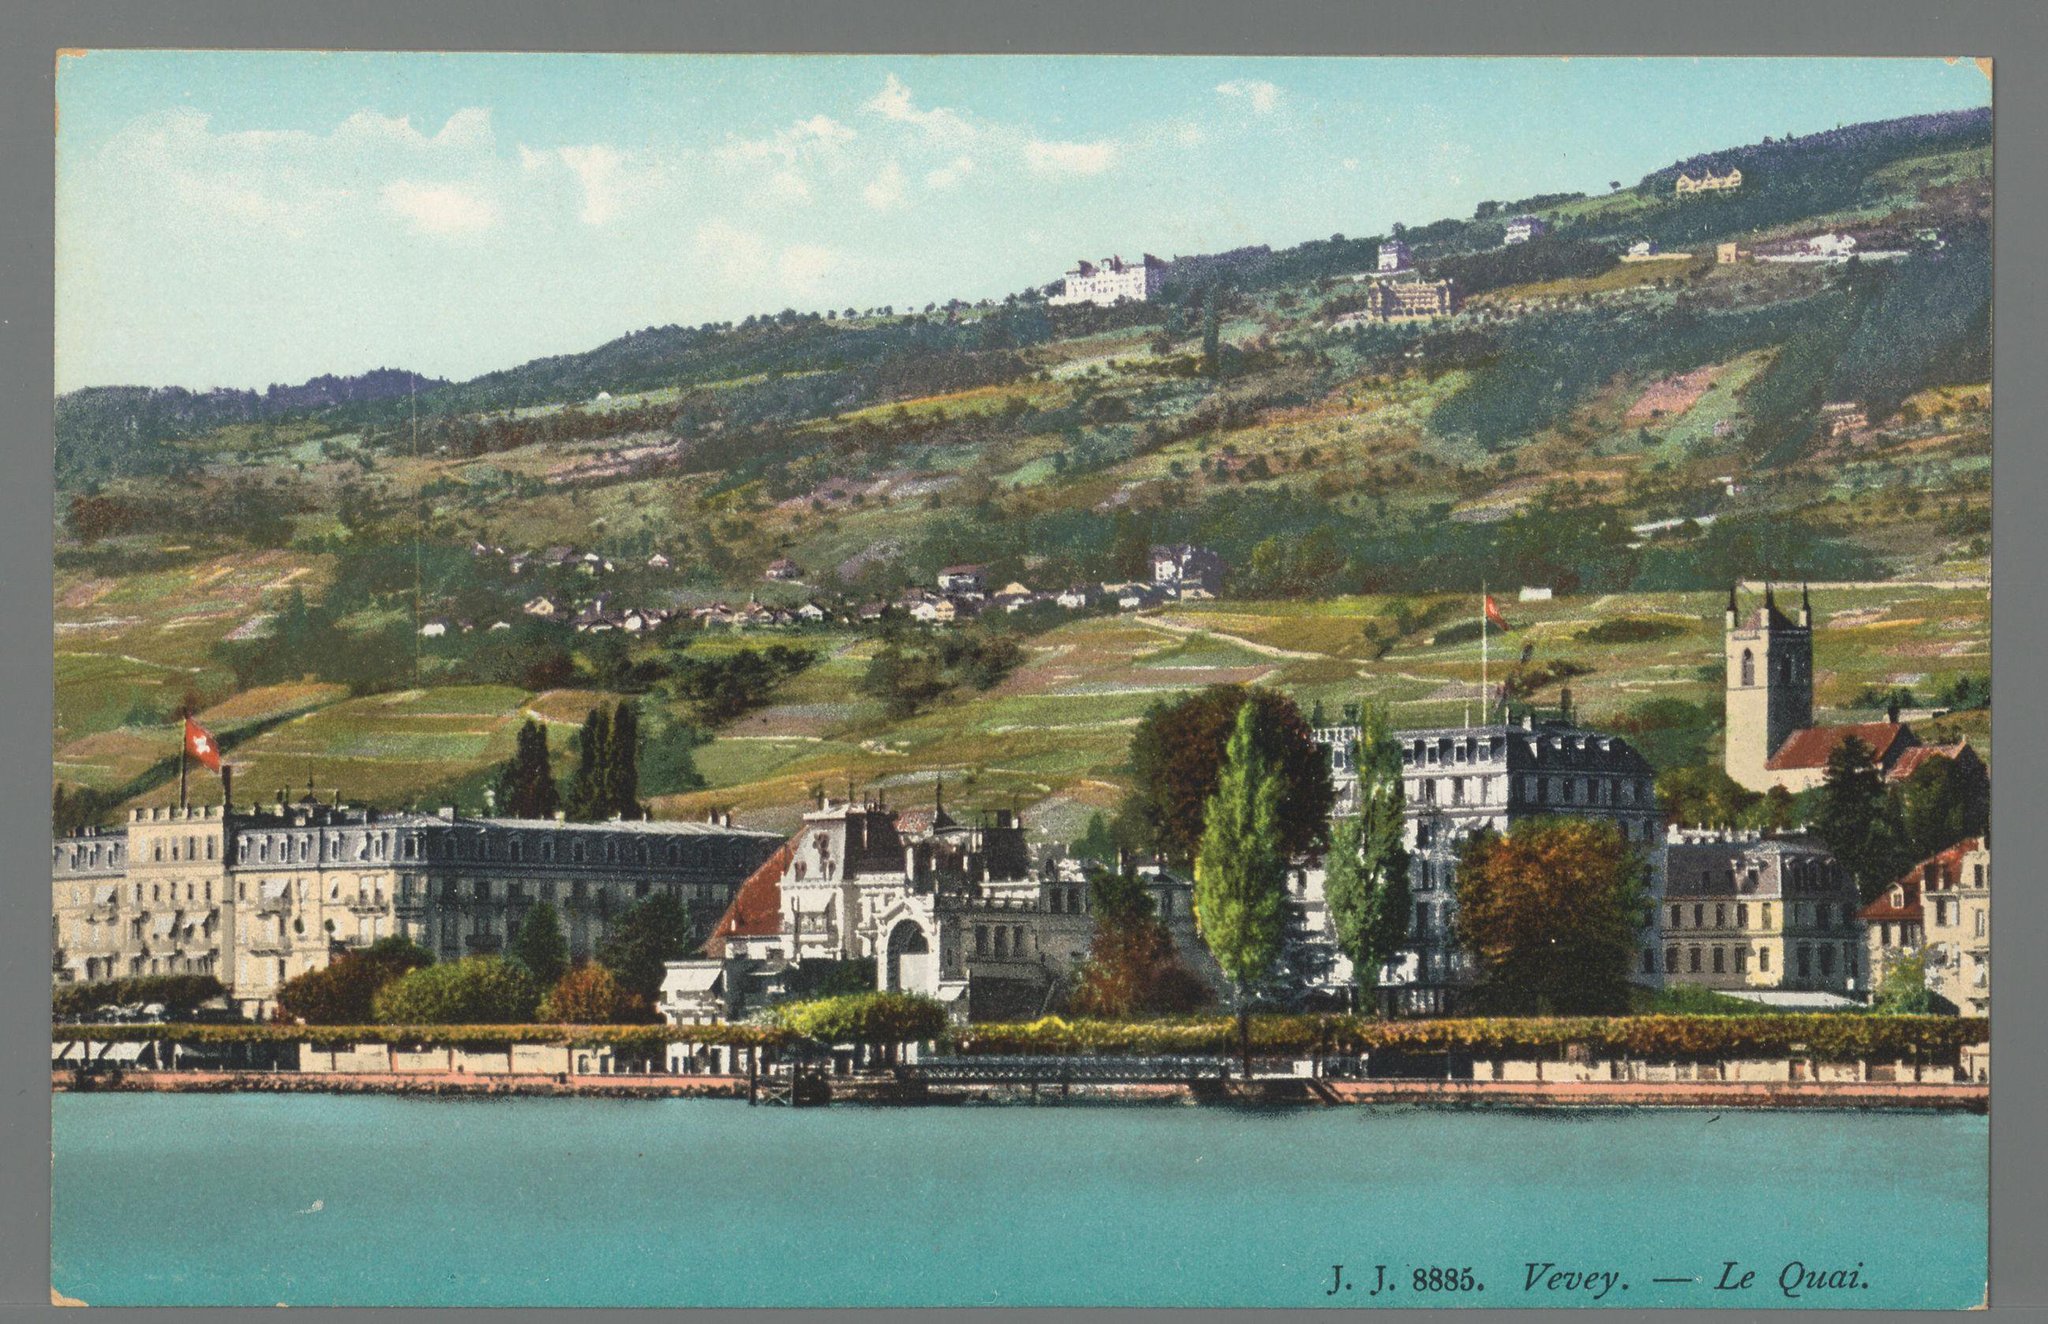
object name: ansichtkaart, prentbriefkaart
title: Vevey. Le Quai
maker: Anonymous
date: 1905-1918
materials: cardboard, photographic process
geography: vevey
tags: church (exterior), lake, prospect of city, town panorama, silhouette of city